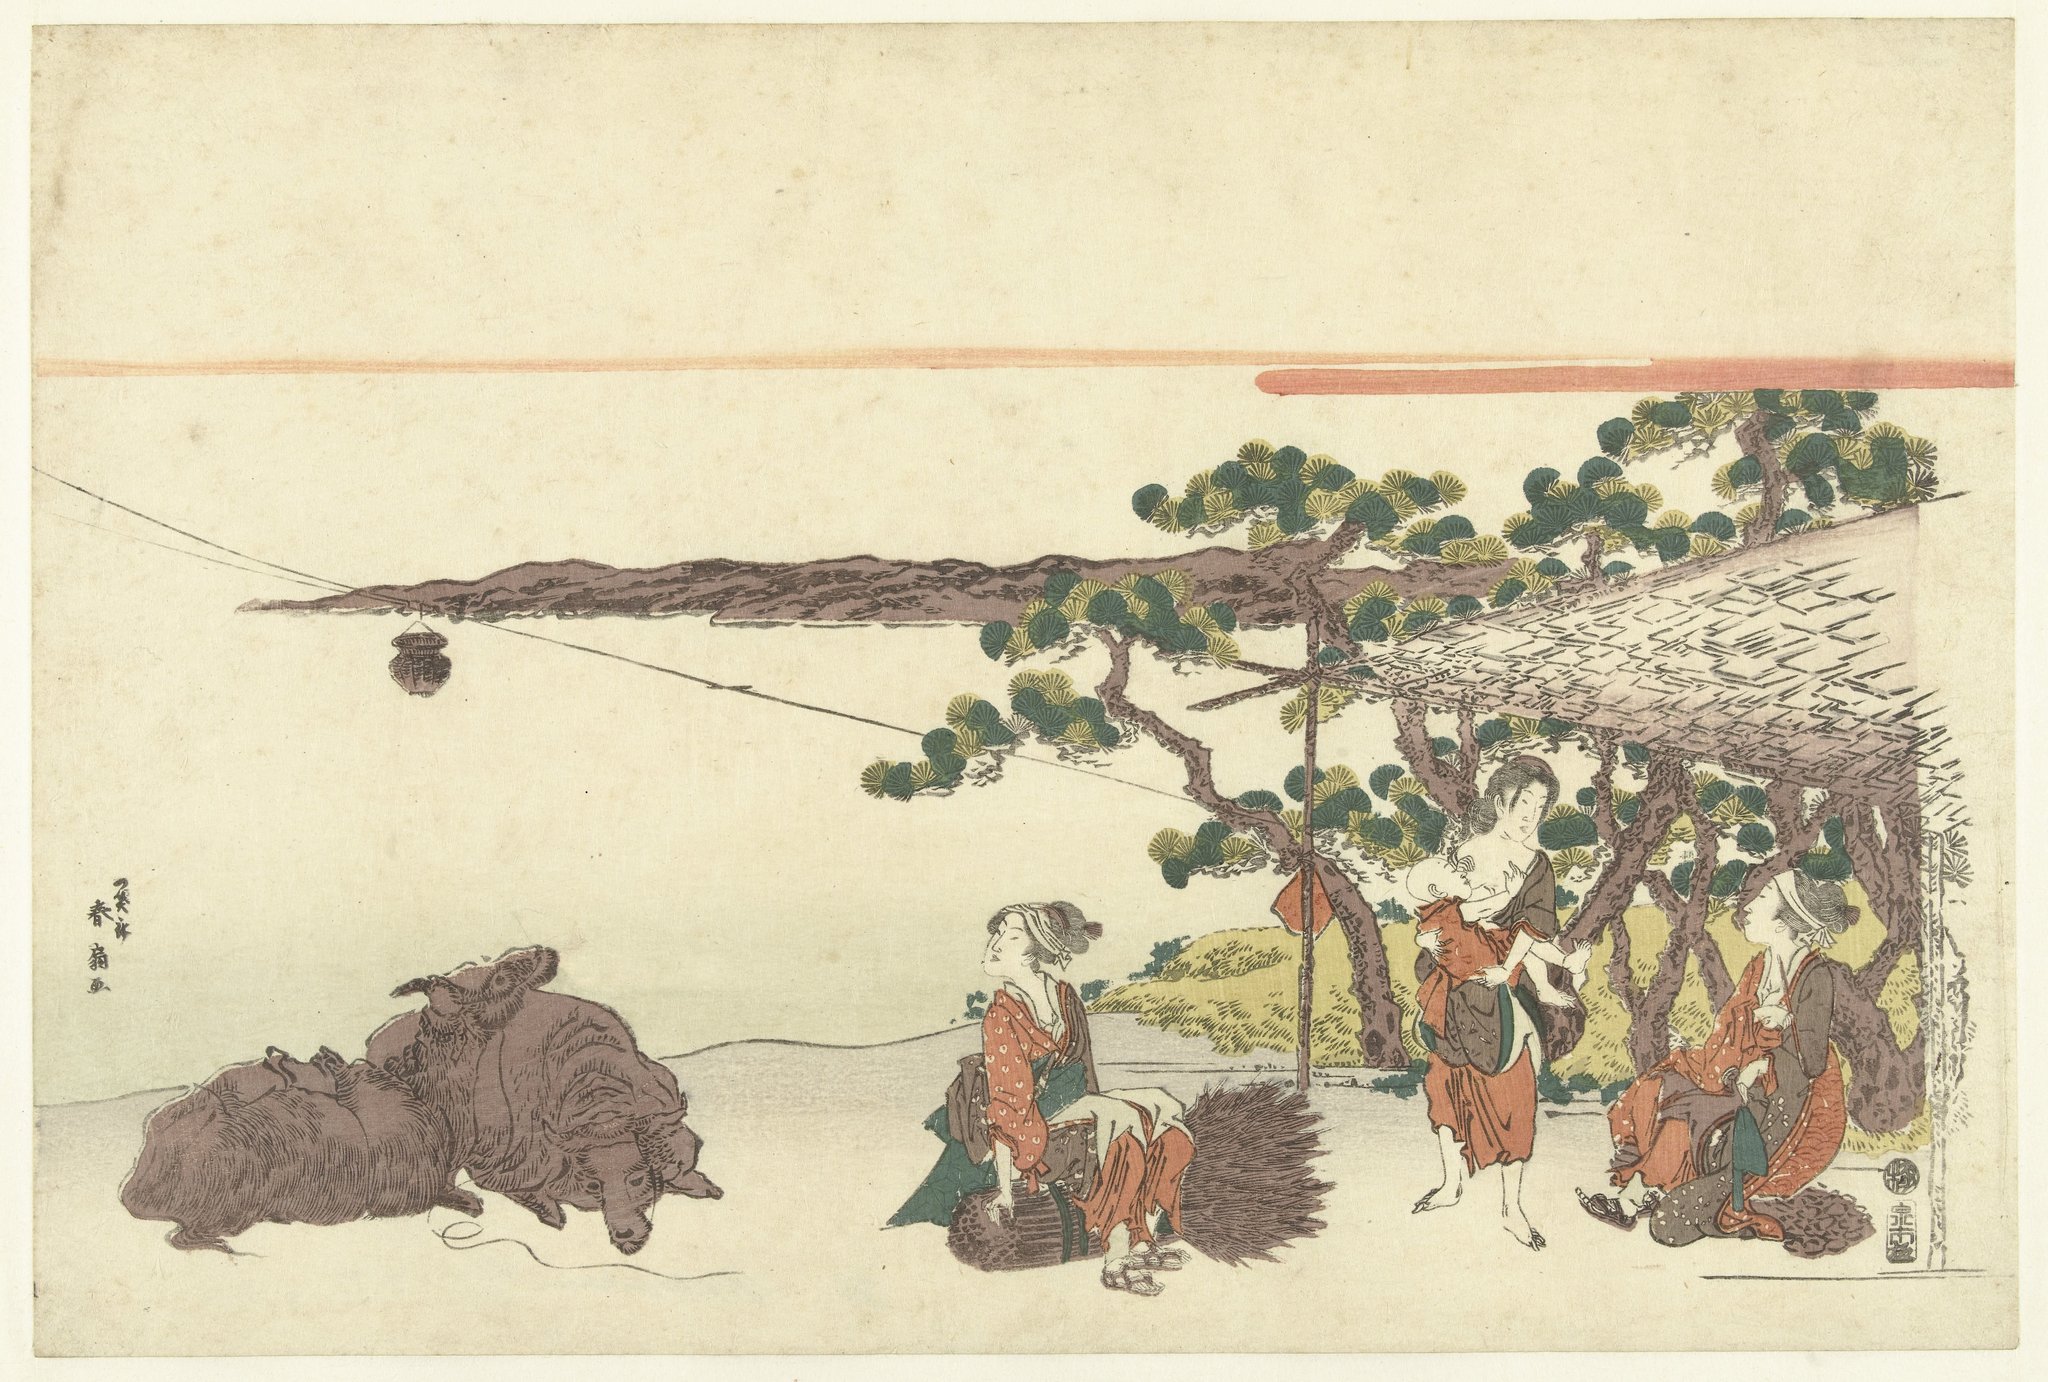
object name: print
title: Vrouwen bij een meer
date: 1820-1830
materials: paper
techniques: blind stamped, woodcut, nishiki e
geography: japan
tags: lake, adult woman (+ three persons)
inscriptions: collector's mark: Lugt 2760, collector's mark: Lugt 2228